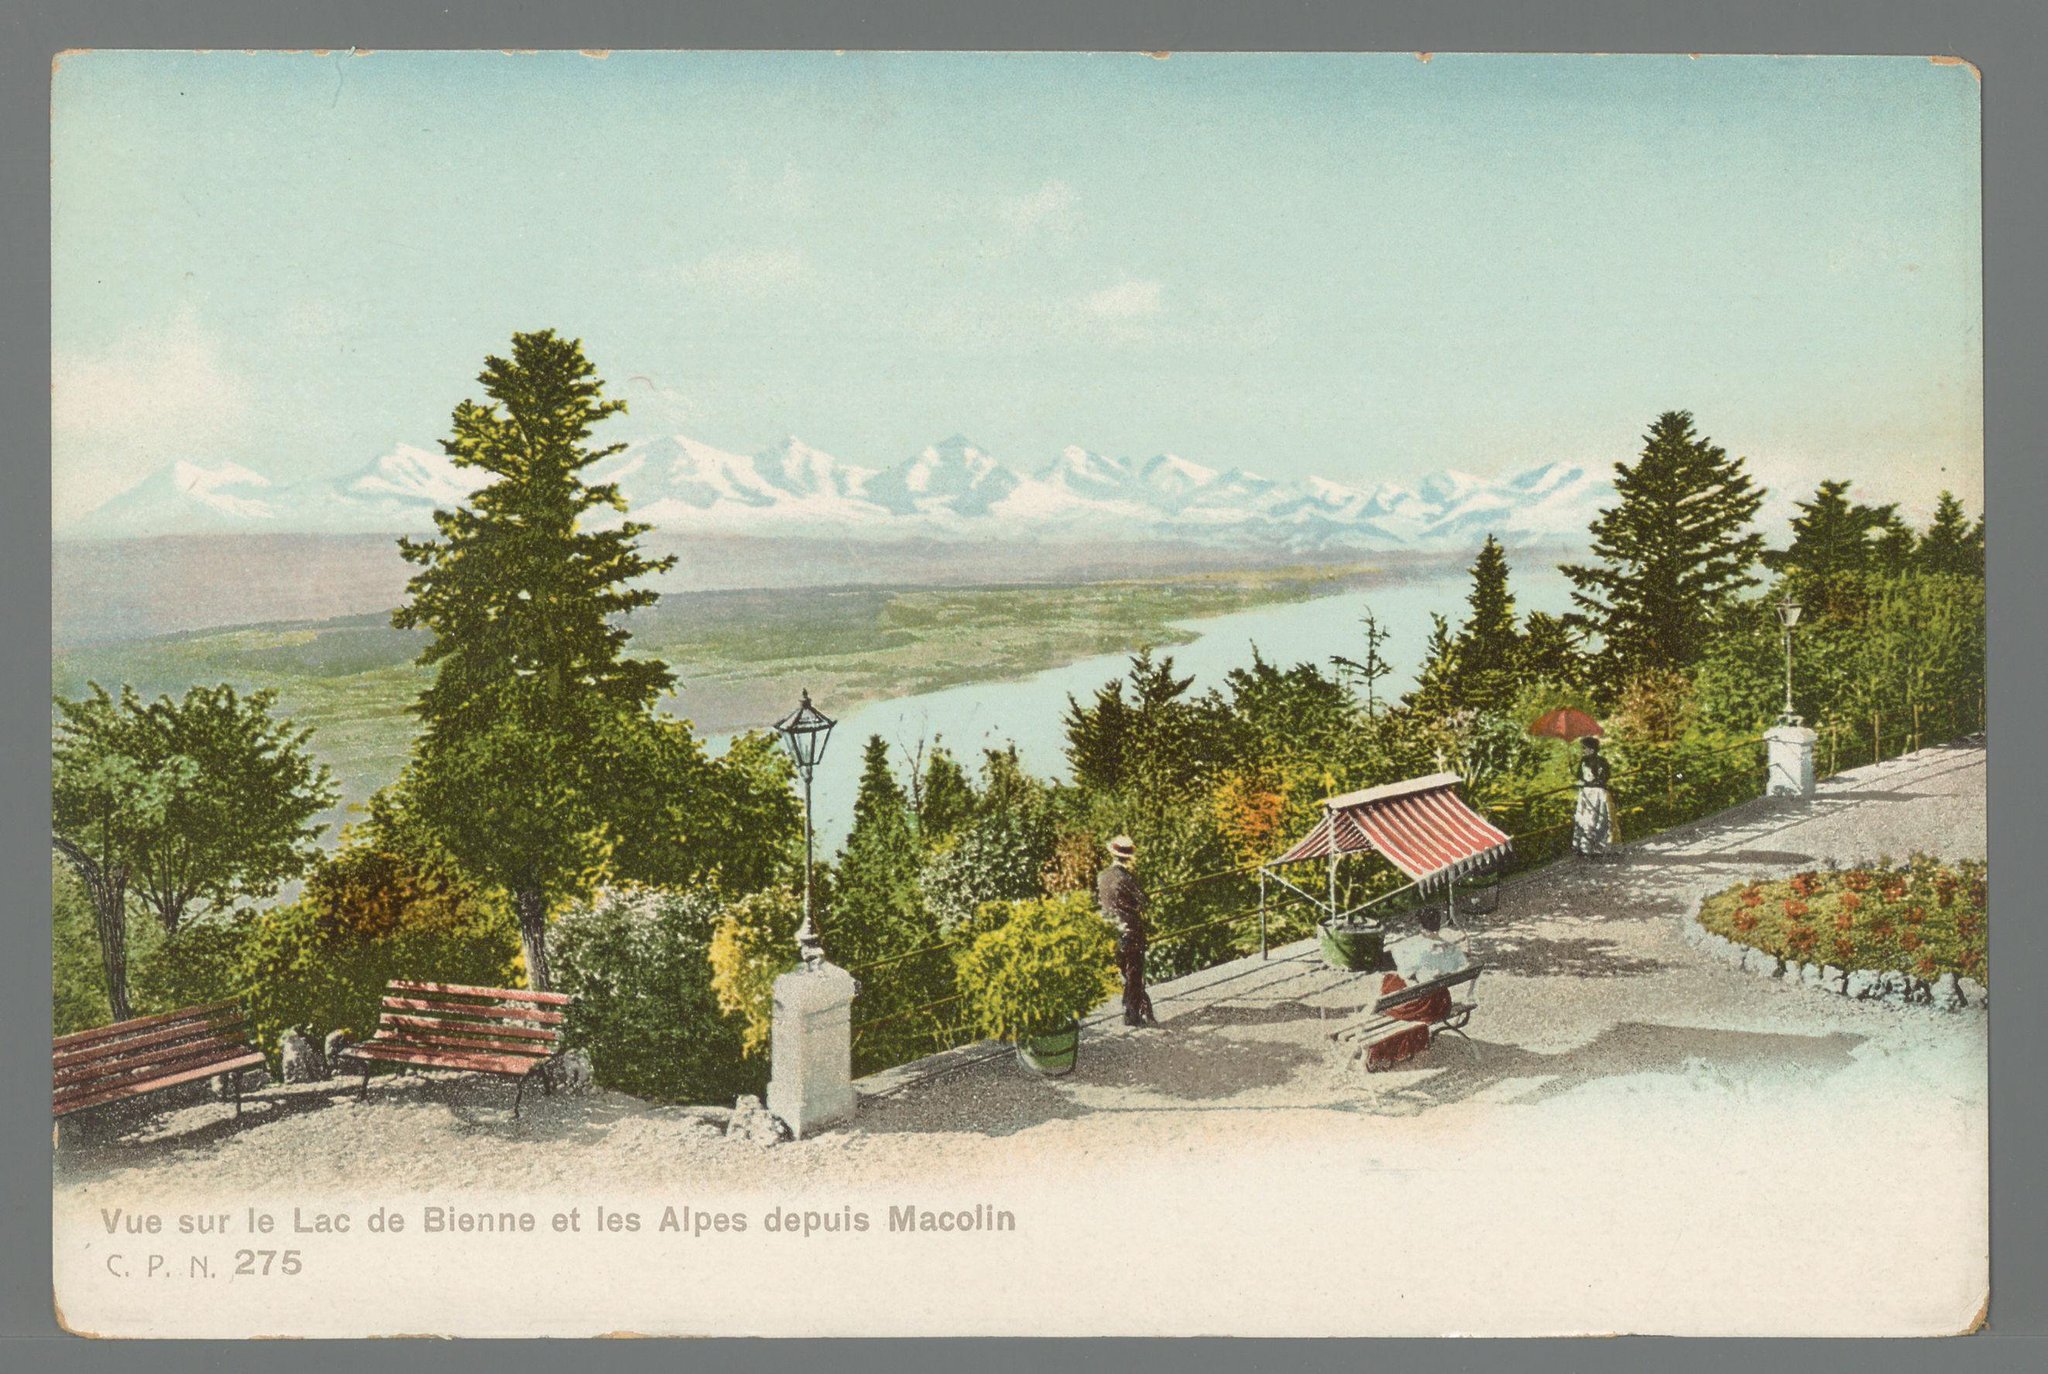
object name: ansichtkaart, prentbriefkaart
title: Vue sur le Lac de Bienne et les Alpes depuis Macolin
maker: Anonymous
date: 1898-1905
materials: cardboard, photographic process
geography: magglingen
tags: lake, mountain-range, snow peaks, public gardens, park